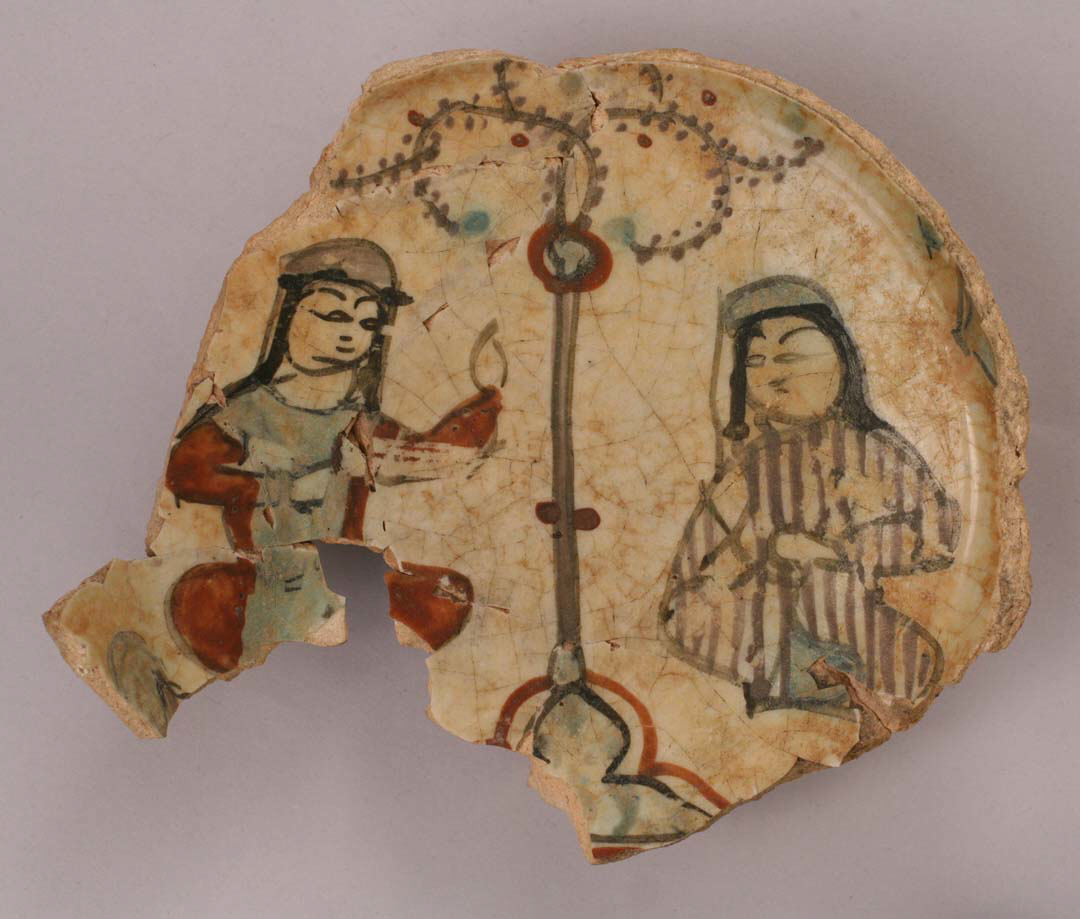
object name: fragment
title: Fragment of a Bowl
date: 1101-1300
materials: stonepaste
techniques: overglaze, painting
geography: iran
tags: human figures